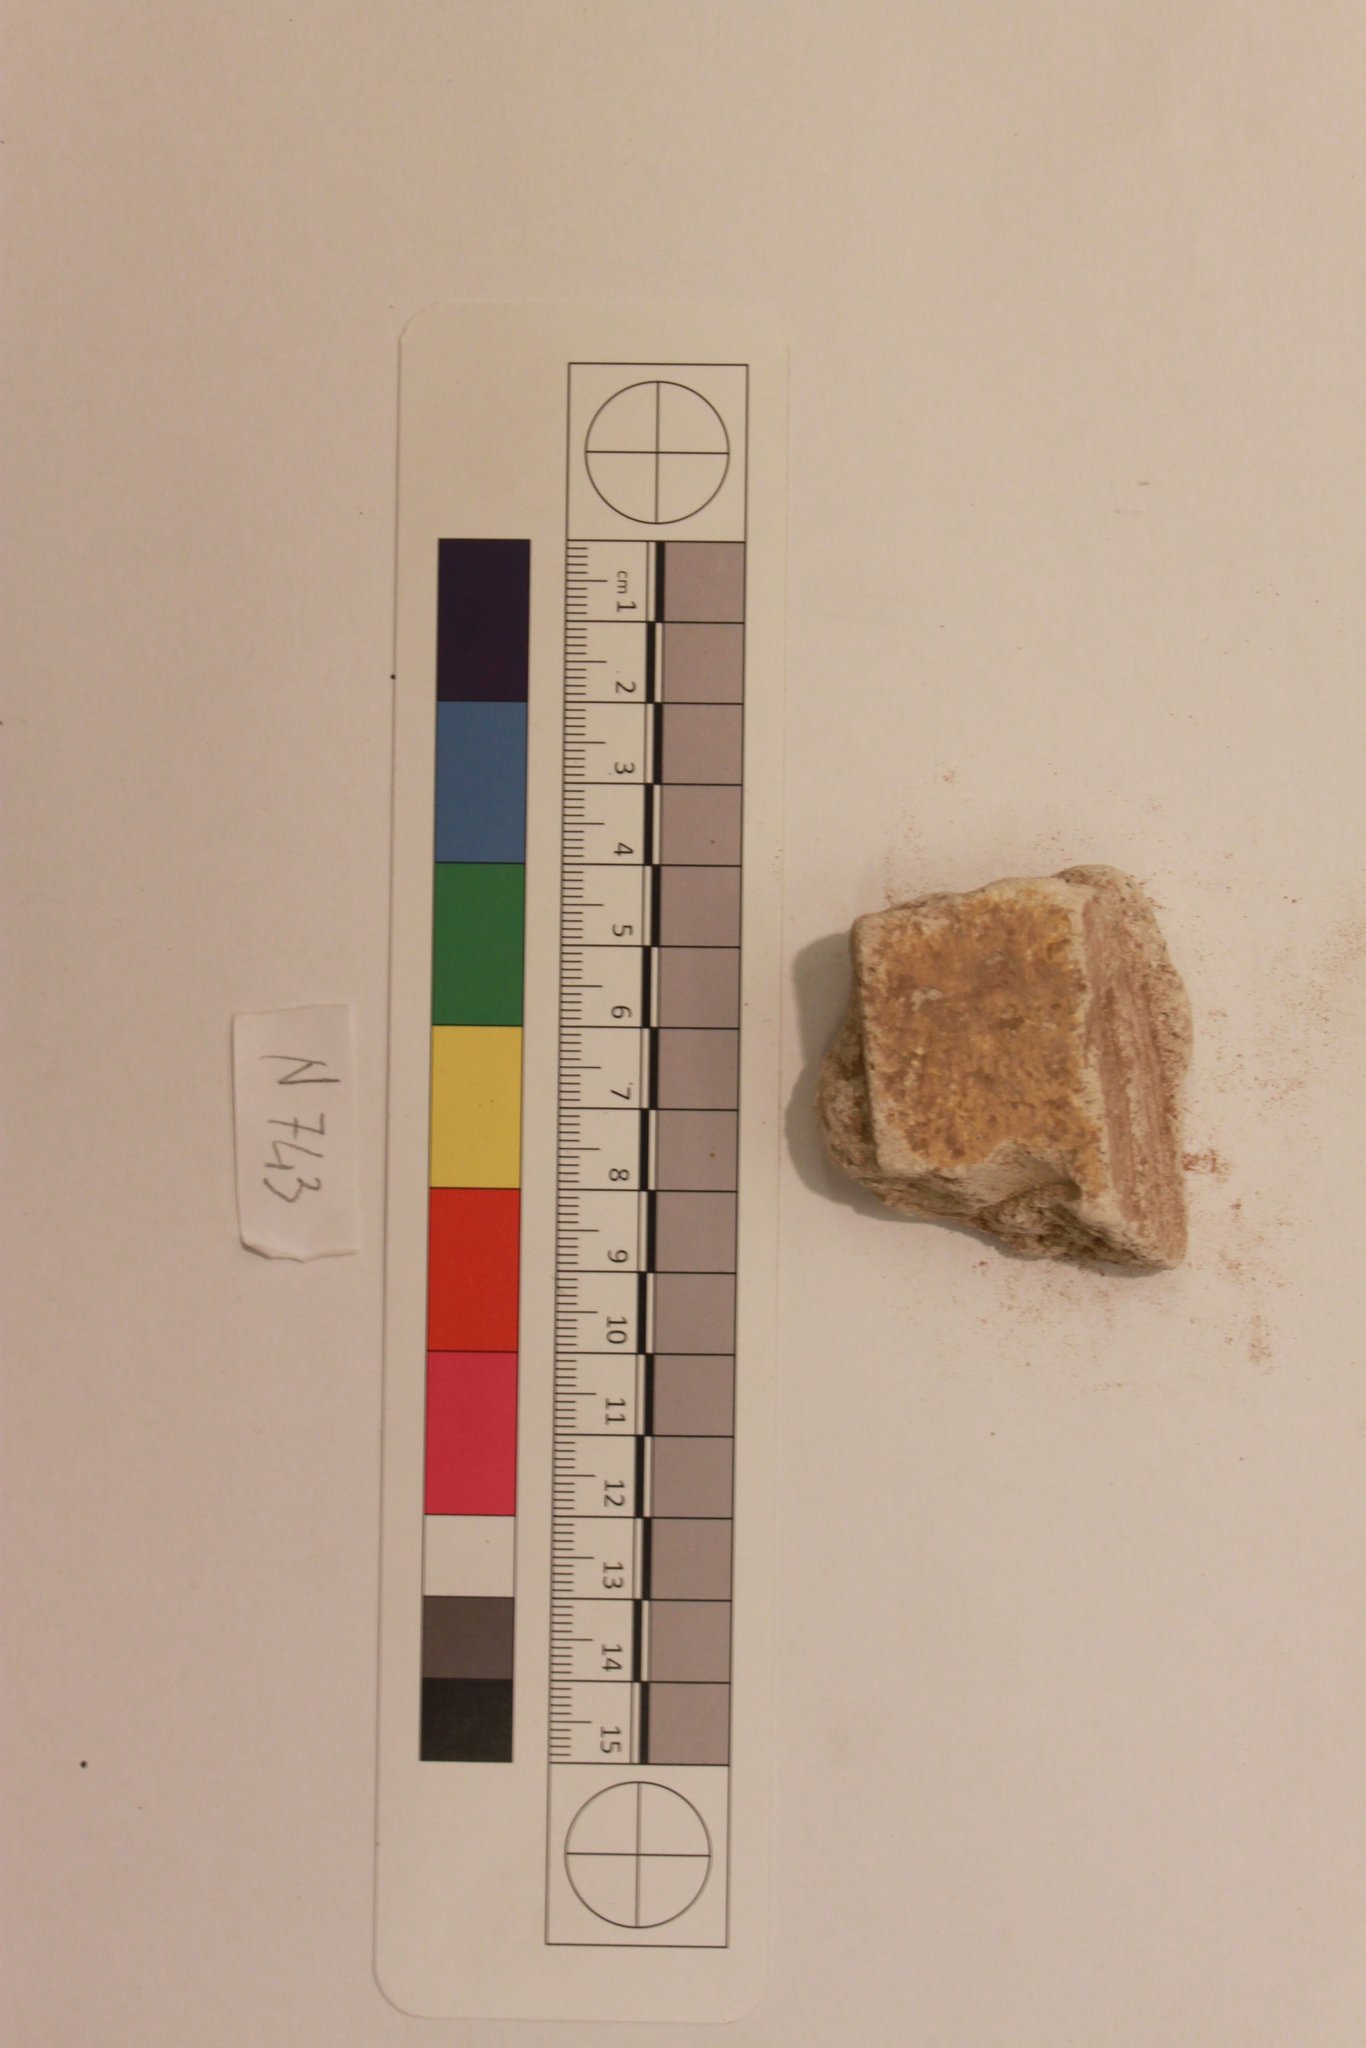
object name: fragment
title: Stucco Fragment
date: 701-1200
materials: plaster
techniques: carving, painting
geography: iran